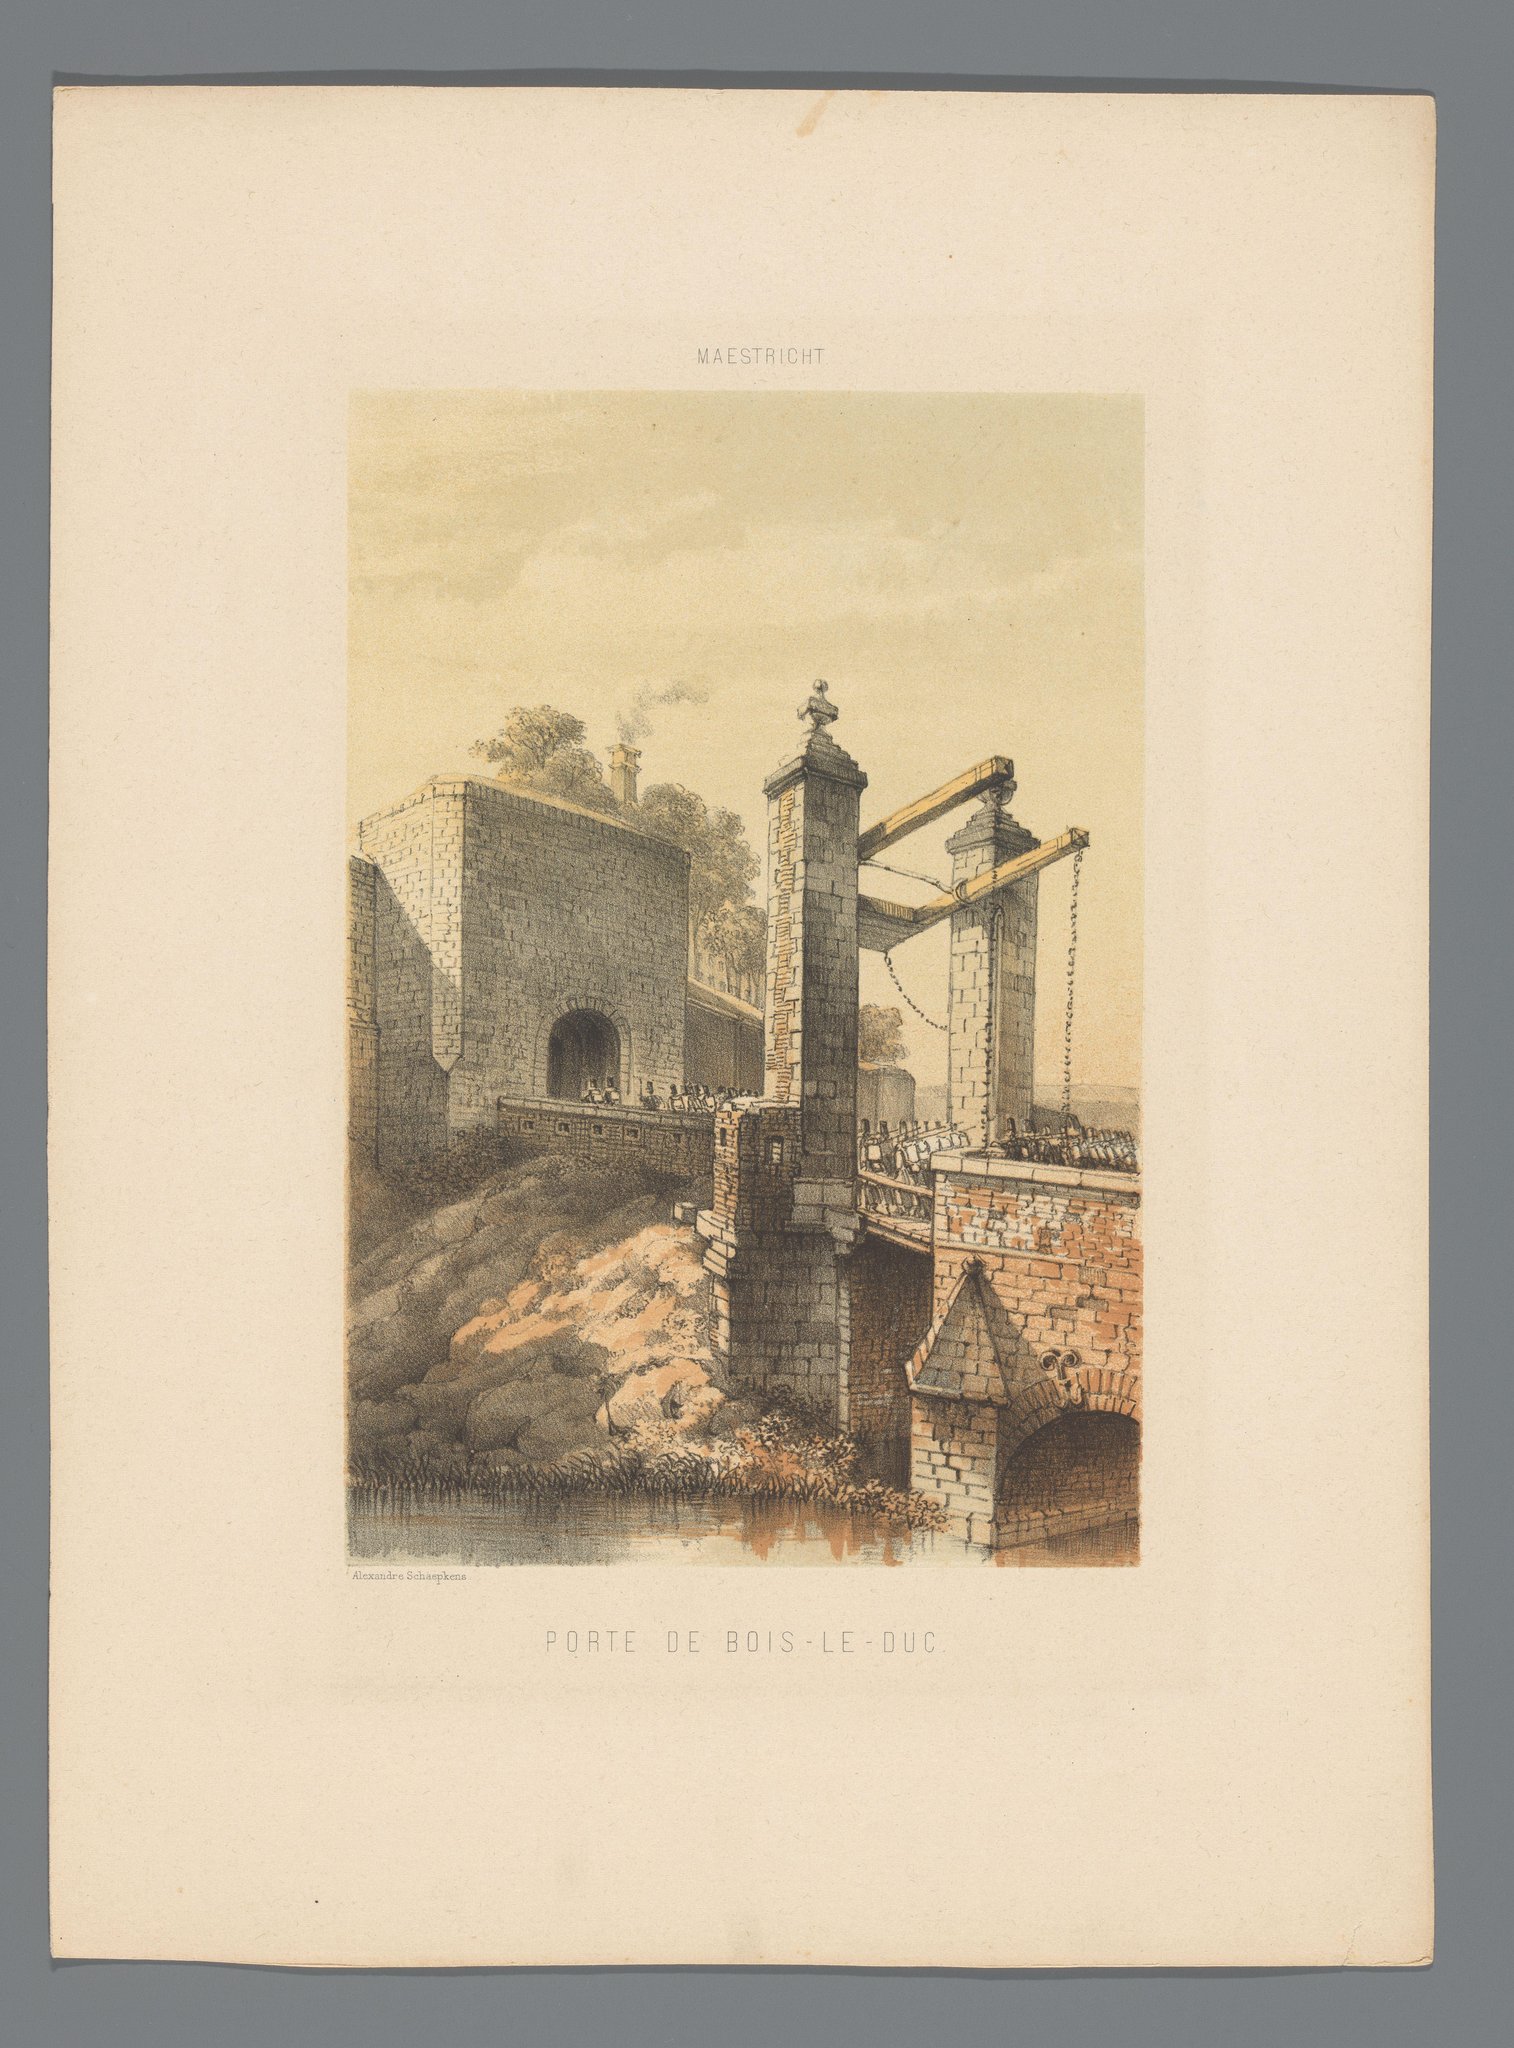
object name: print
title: Porte de Bois-le-duc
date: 1857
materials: paper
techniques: tone lithography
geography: brussels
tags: city-gate, maastricht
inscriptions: collector's mark: Lugt 2228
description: Veldzijde van de poort. Over de brug loopt een stoet soldaten. Onderdeel van een omslag met een serie van tien lithografieën van monumenten te Maastricht.